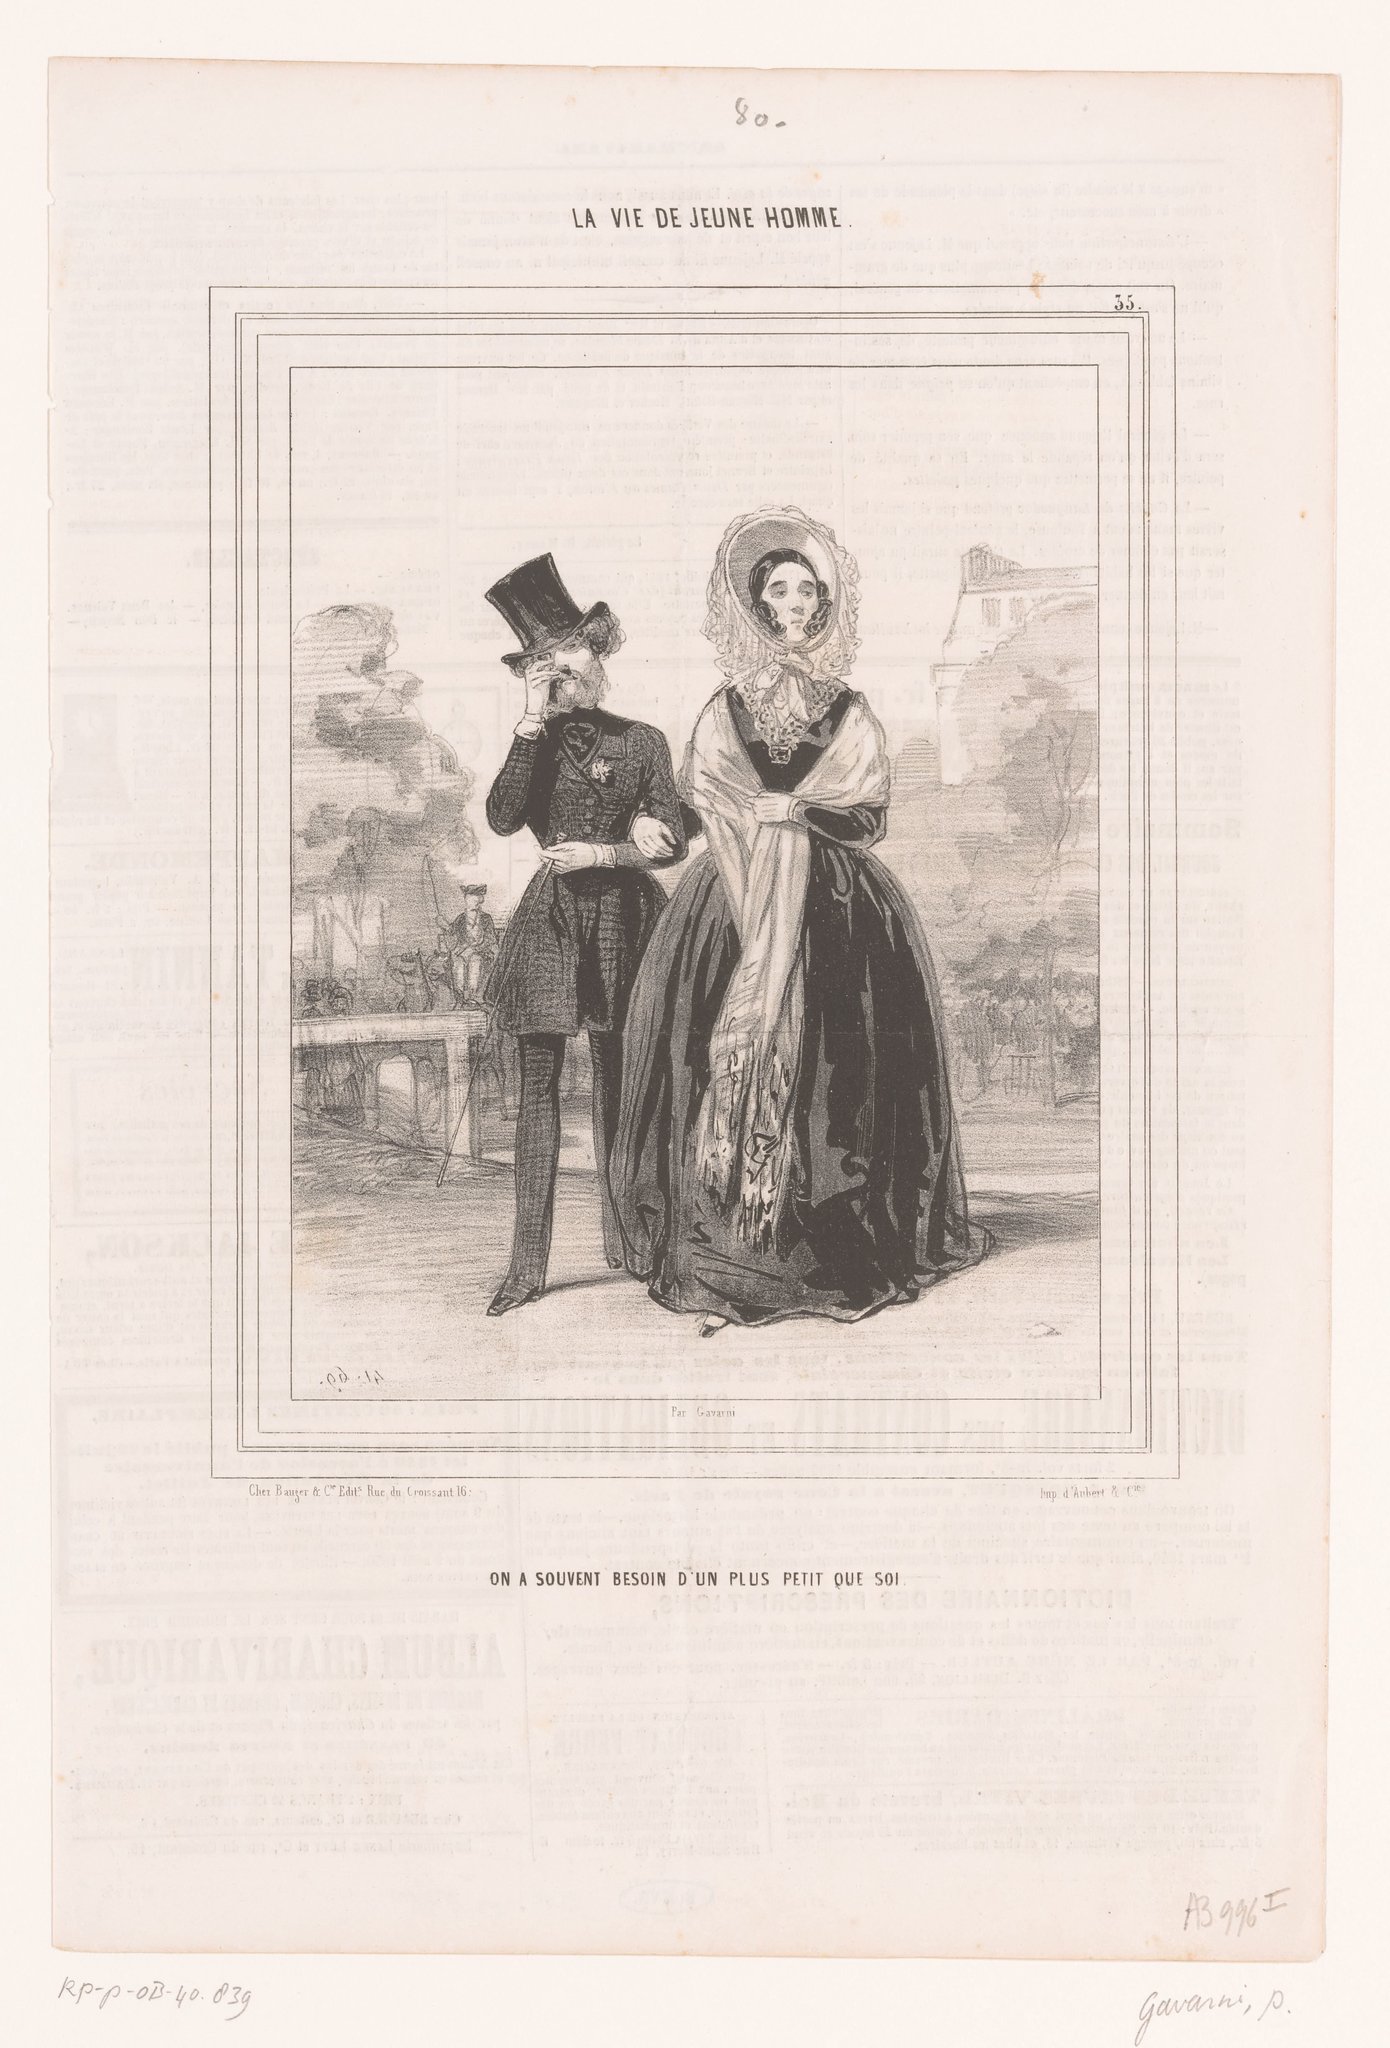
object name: cartoon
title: Lange vrouw wandelt met een kortere jongeman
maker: paul gavarni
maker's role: draughtsman, print maker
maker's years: 1804-1866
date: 1841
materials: paper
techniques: lithograph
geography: paris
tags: walking, hiking (recreation), dandy, beau, married couple of unequal size, fashionable woman, 'belle'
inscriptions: collector's mark: Lugt 2228a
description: Prent gebruikt voor: Le Charivari, 5 augustus 1841.